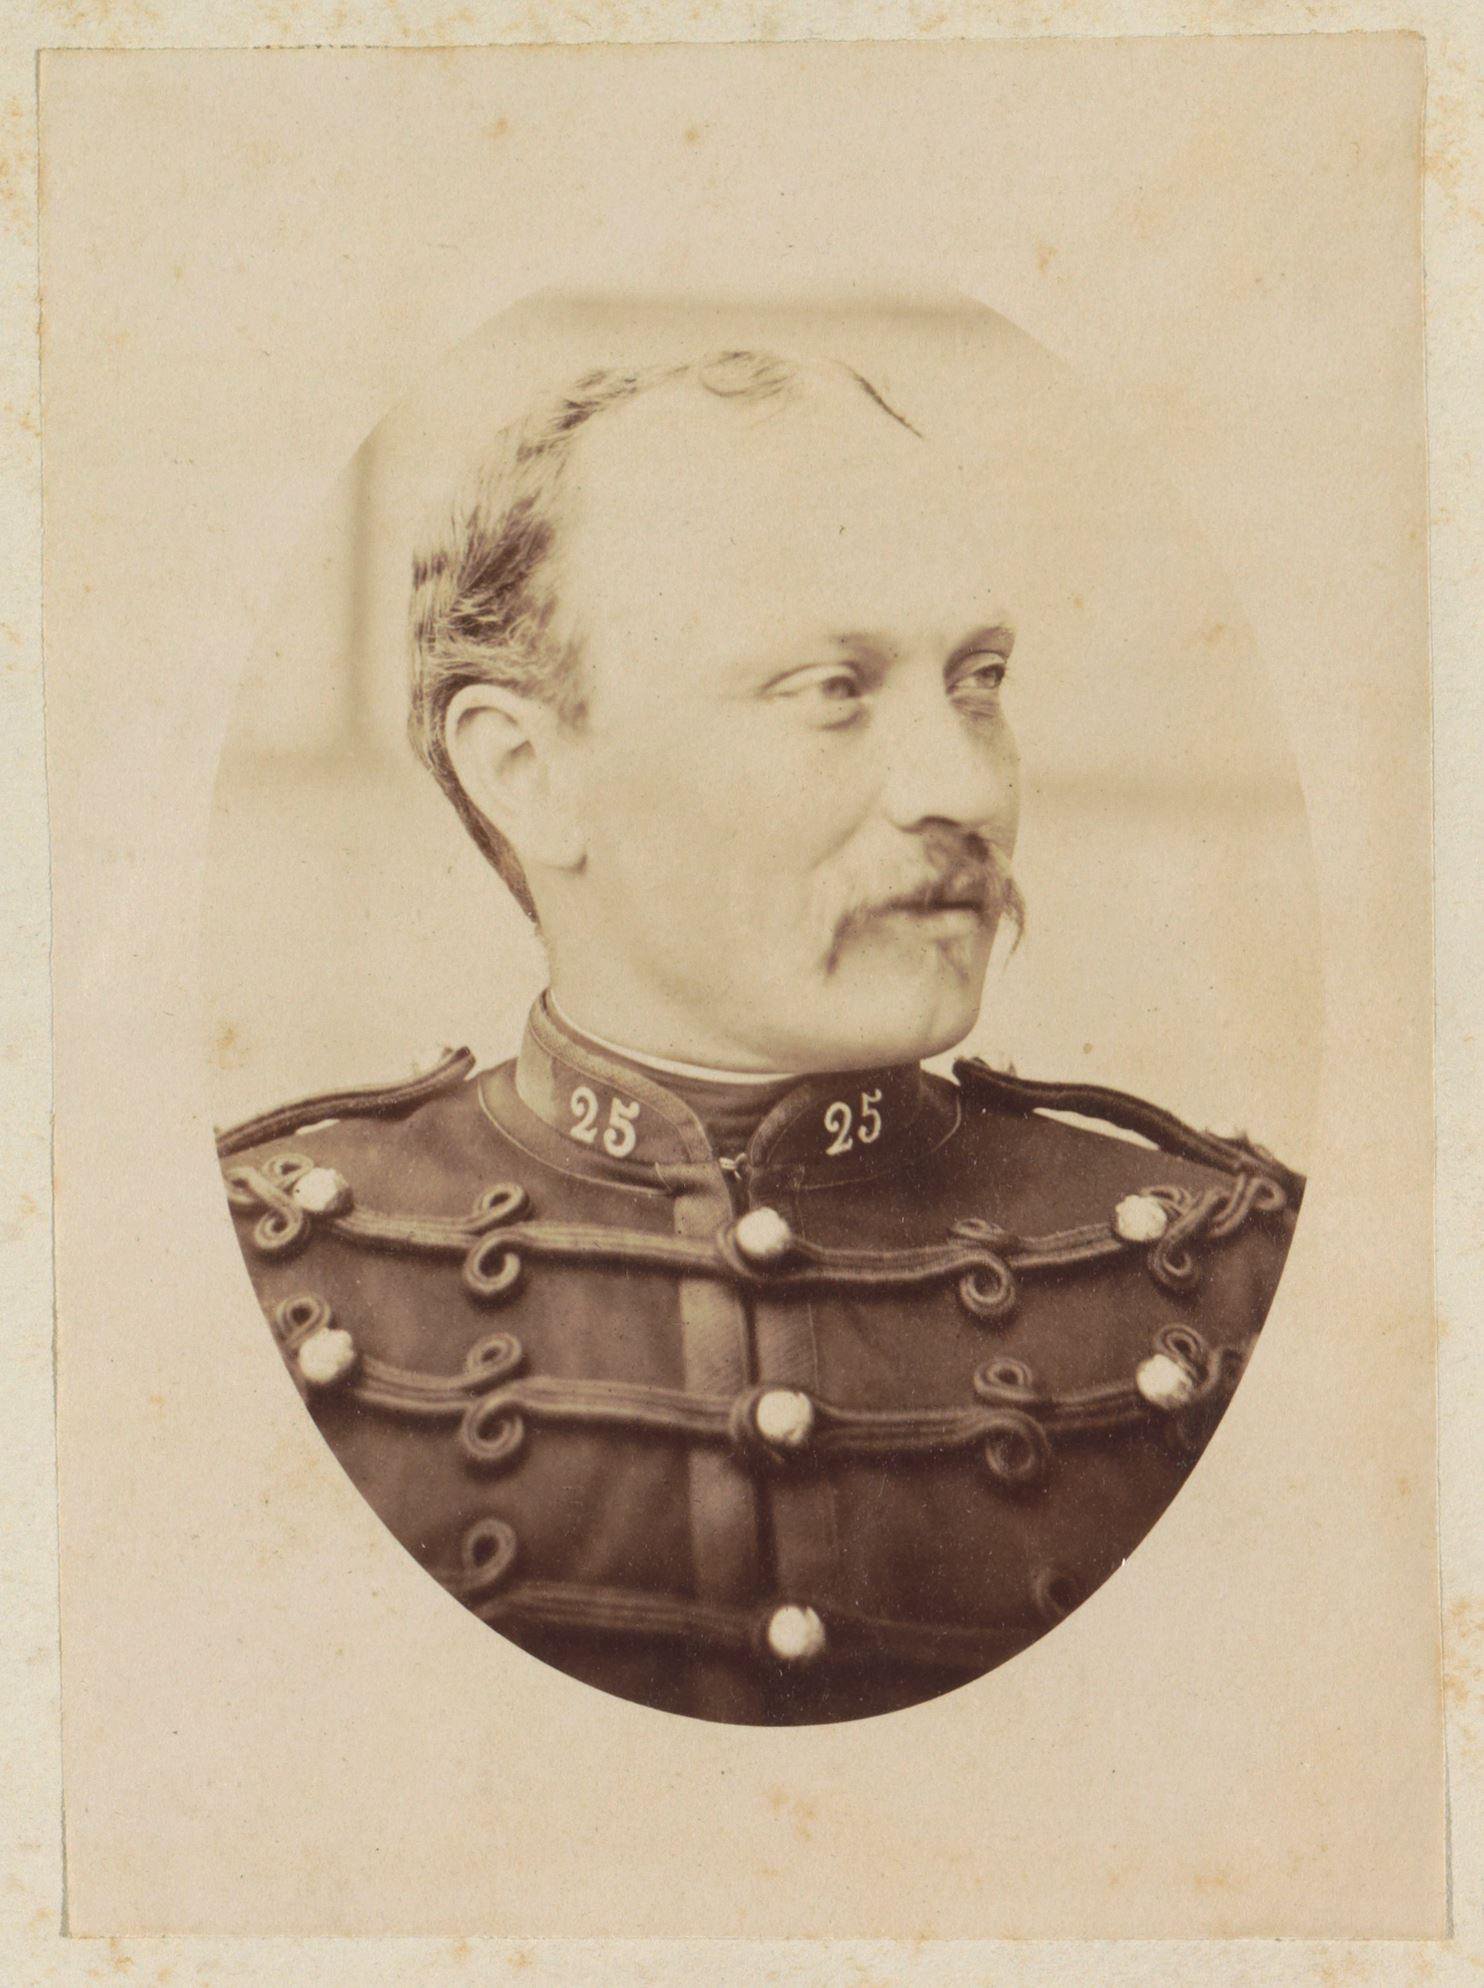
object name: photograph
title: Portret van een onbekende Franse militair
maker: Anonymous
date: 1884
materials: photographic support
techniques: albumen print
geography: france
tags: adult man, land forces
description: Onderdeel van Album van een Franse amateurfotograaf met opnames van familie, militairen, industrie, landschappen en bezienswaardigheden in Frankrijk.